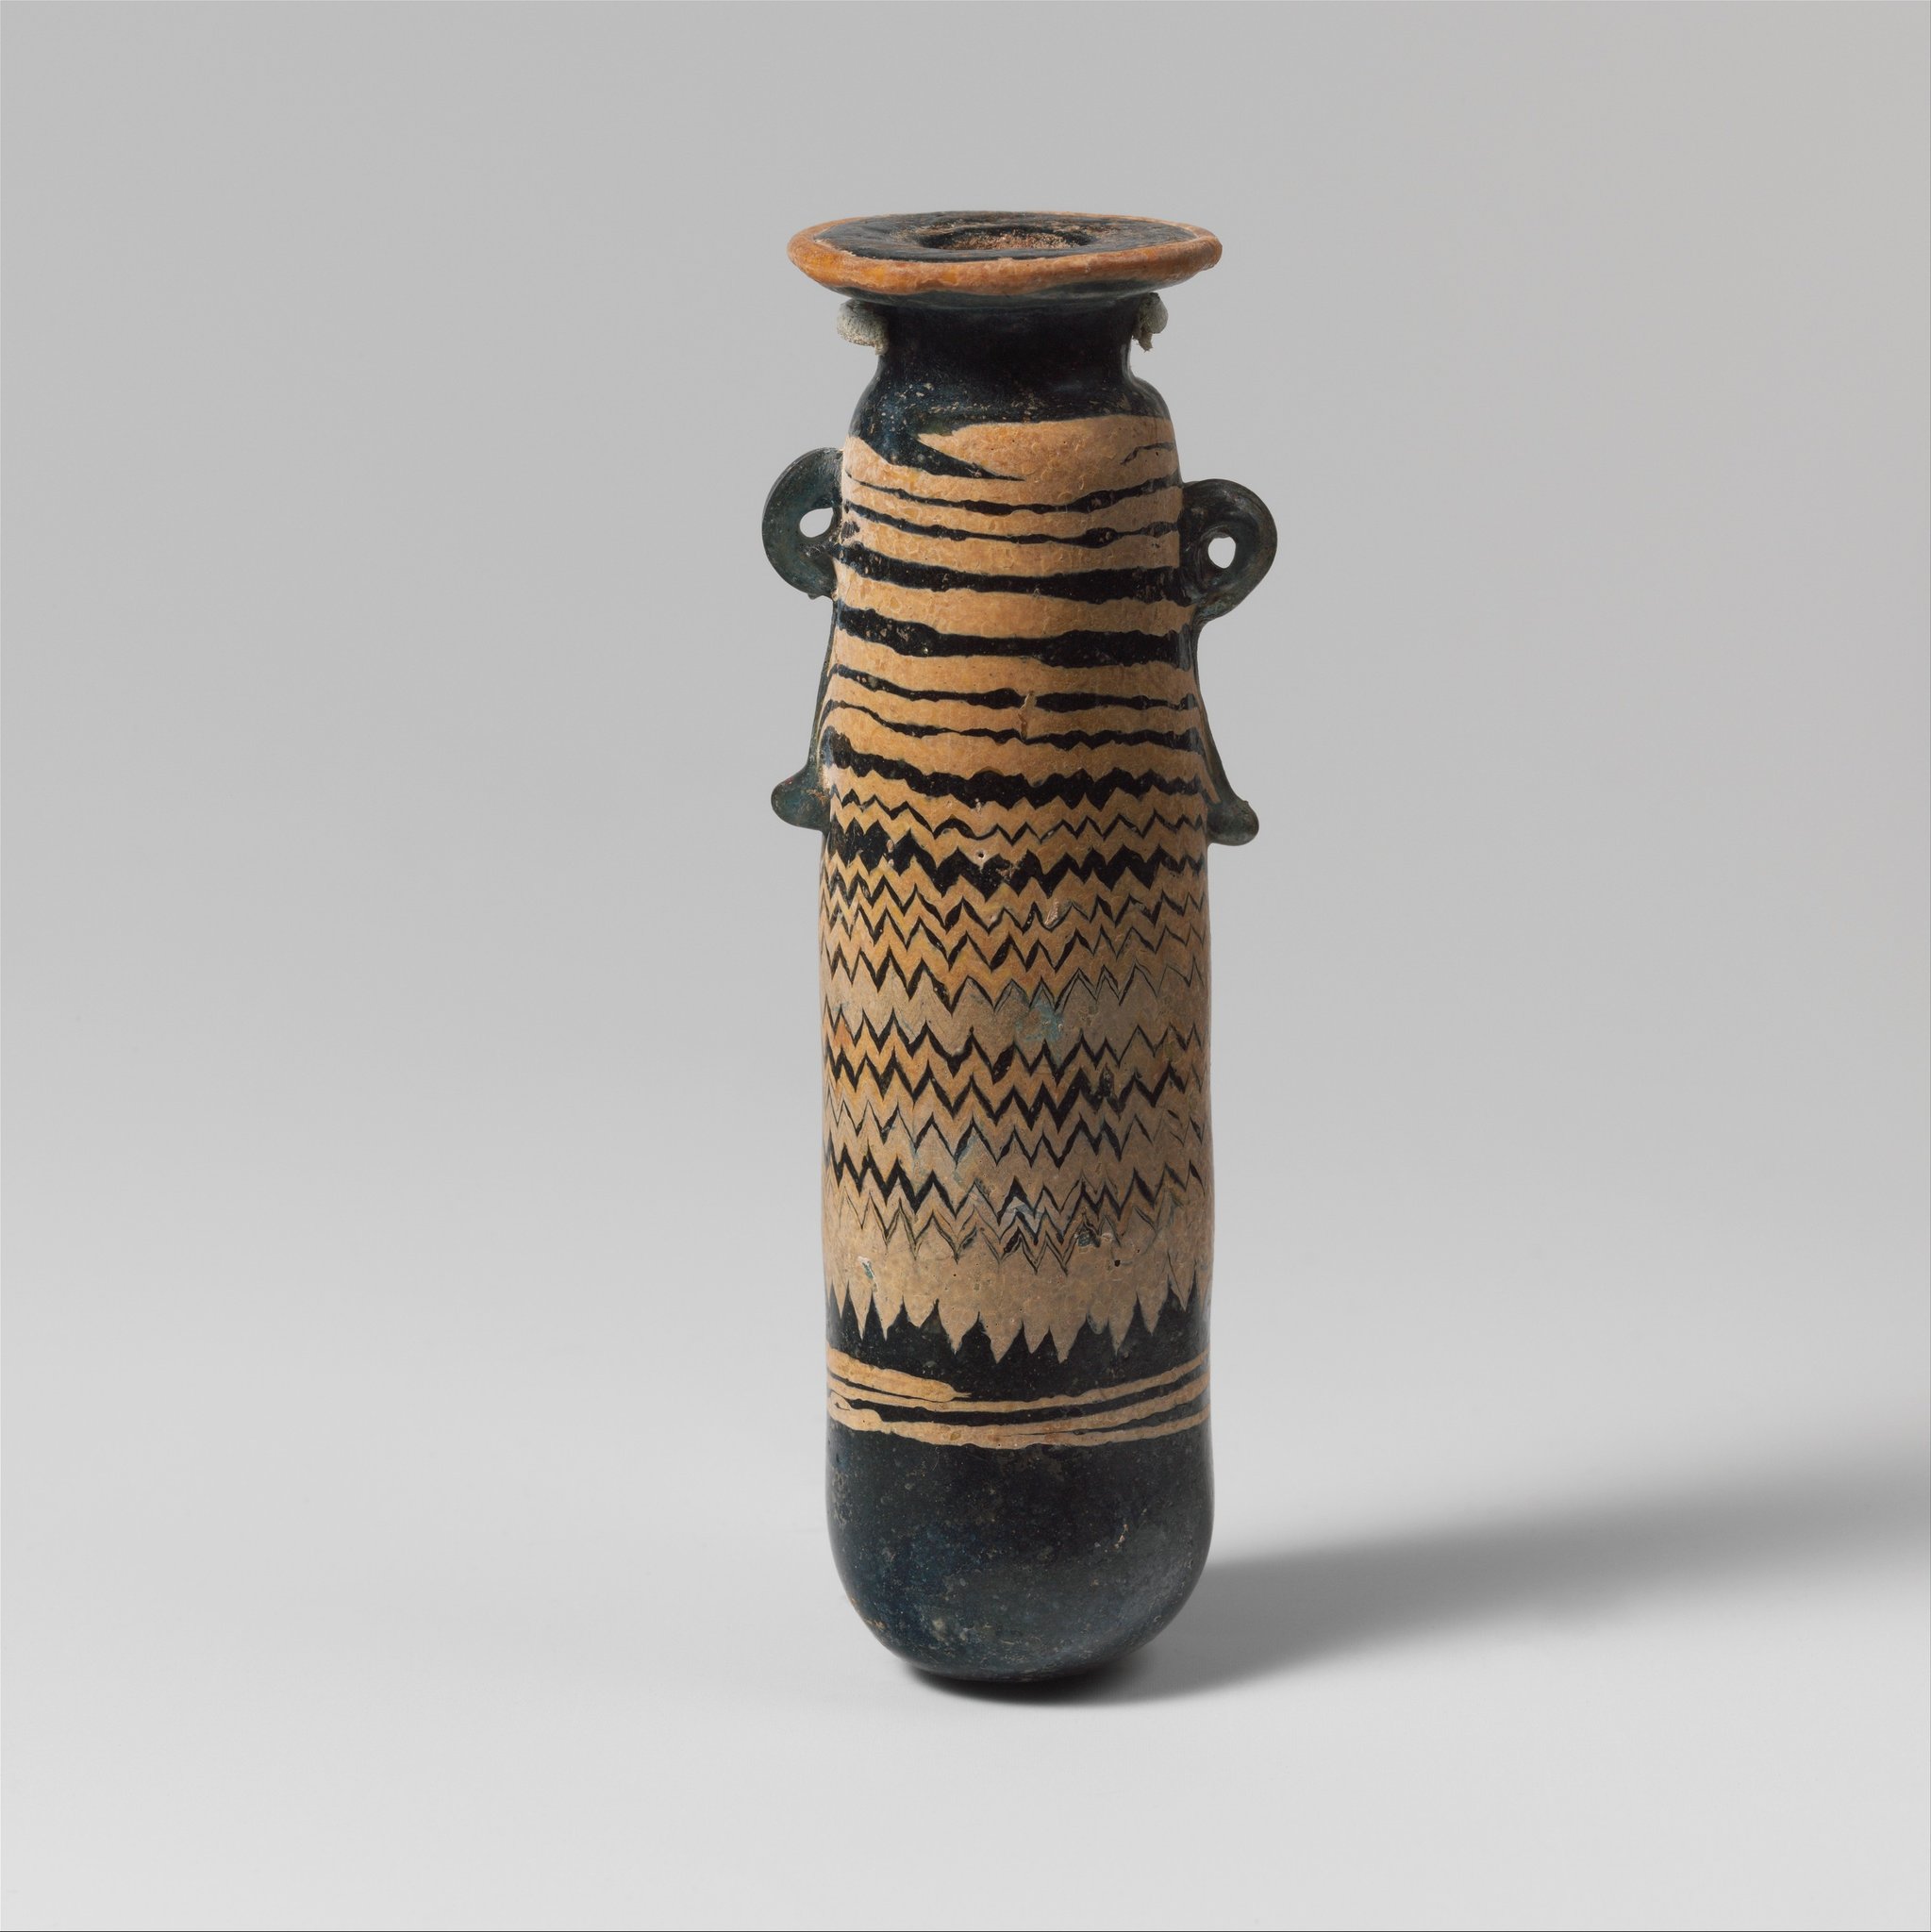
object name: alabastron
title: Glass alabastron (perfume bottle)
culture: greek, eastern mediterranean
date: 534-401 BCE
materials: glass